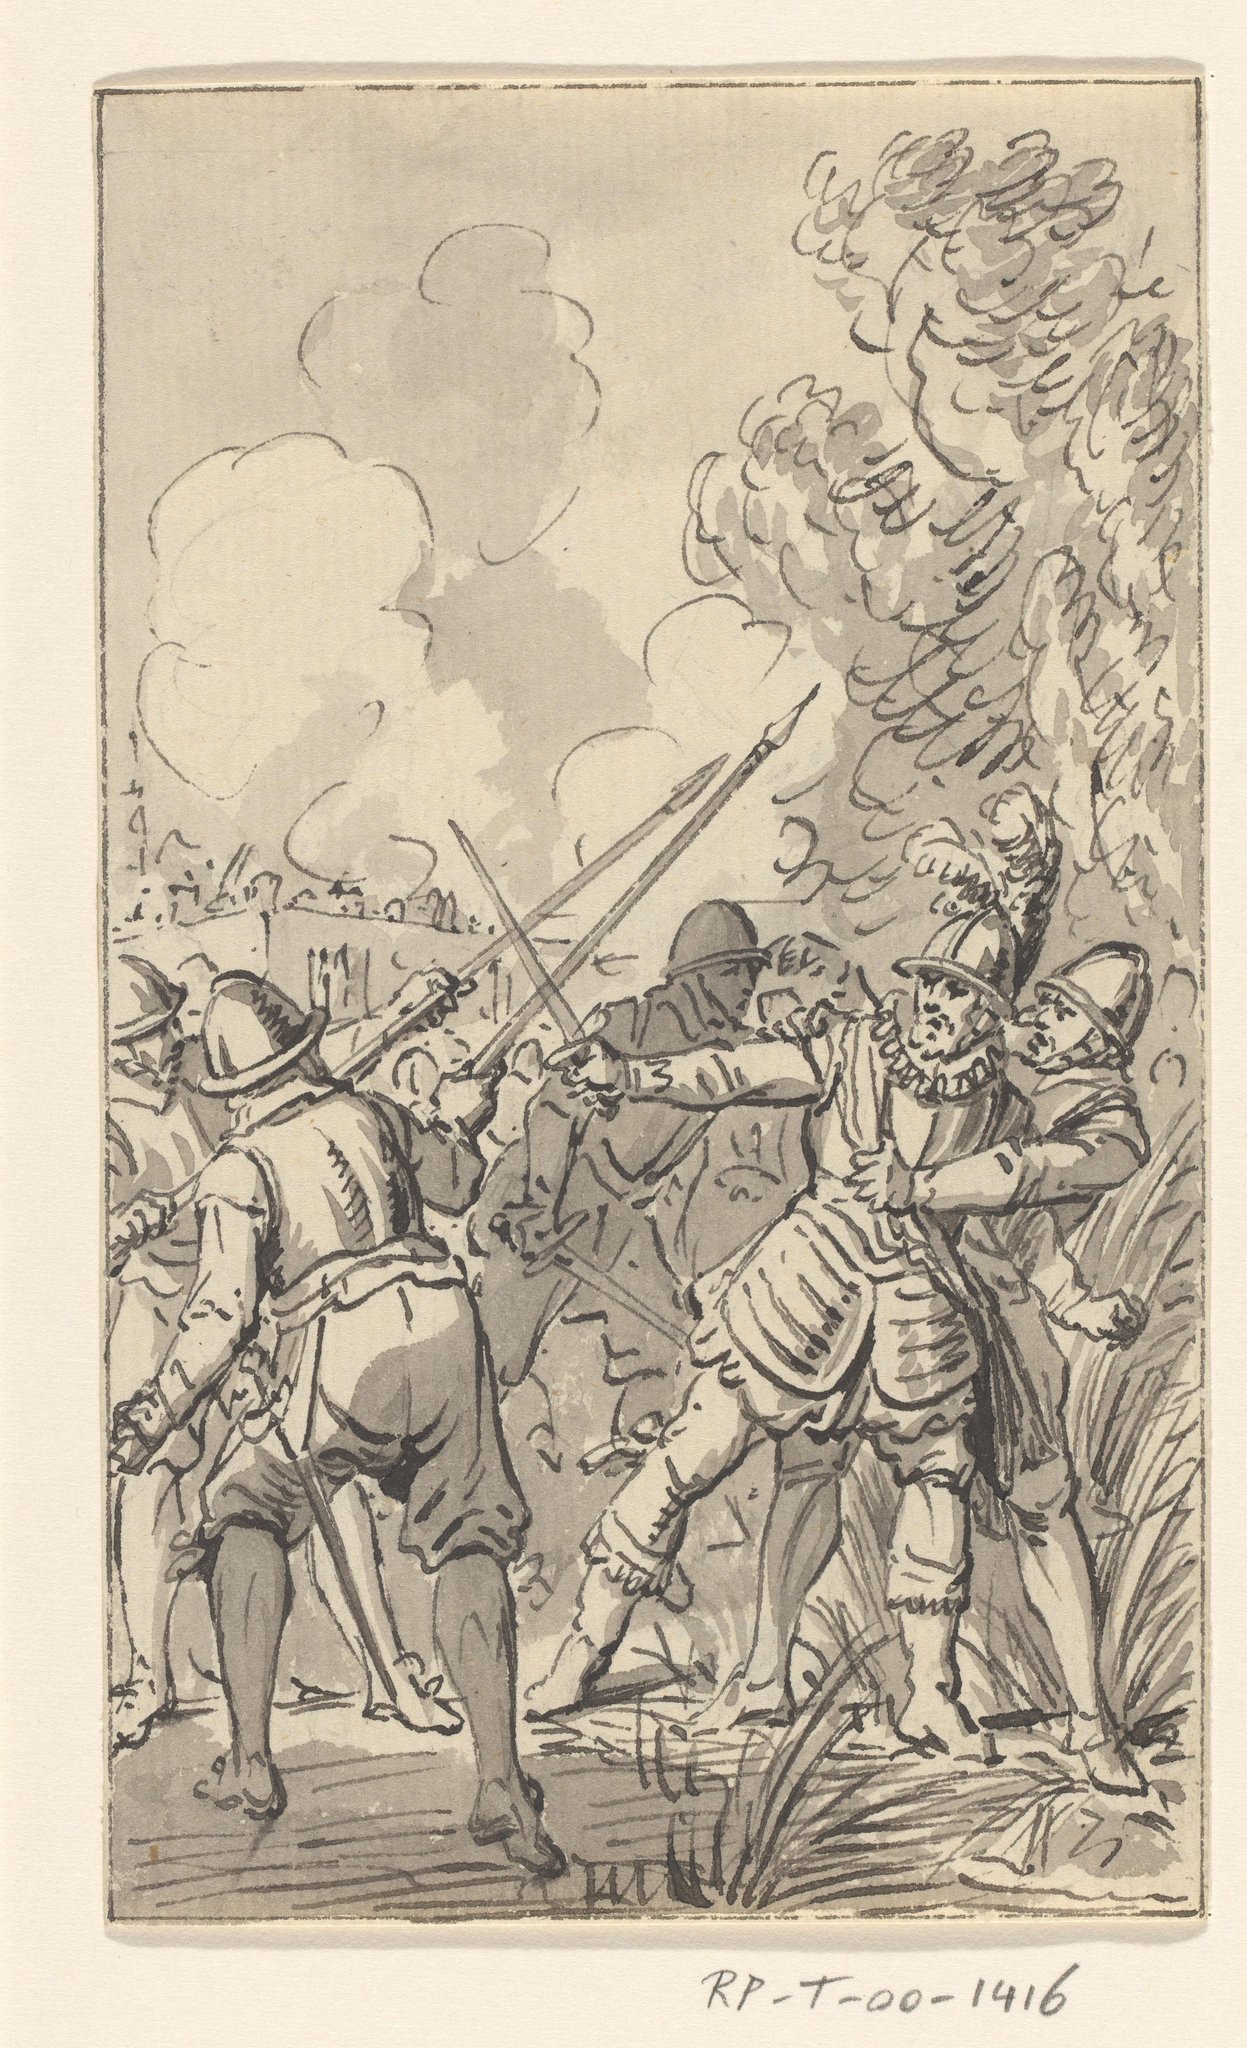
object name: design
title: Gevangenneming van Philips van Marnix door de Spanjaarden bij Maaslandsluis, 1573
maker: jacobus buys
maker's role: draughtsman, print maker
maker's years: 1724-1801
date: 1783-1785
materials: ink, paper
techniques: brush, pen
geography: netherlands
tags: brussels, leiden, politician, filips van marnix van sint-aldegonde, historical persons, prisoner of war (after the battle), historical events and situations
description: Gevangenneming van Filips van Marnix, heer van Sint-Aldegonde, door de Spanjaarden in Maaslandsluis, november 1573. Filips omringd door Spaanse soldaten, verdedigt zich met het zwaard. Ontwerp voor een prent.